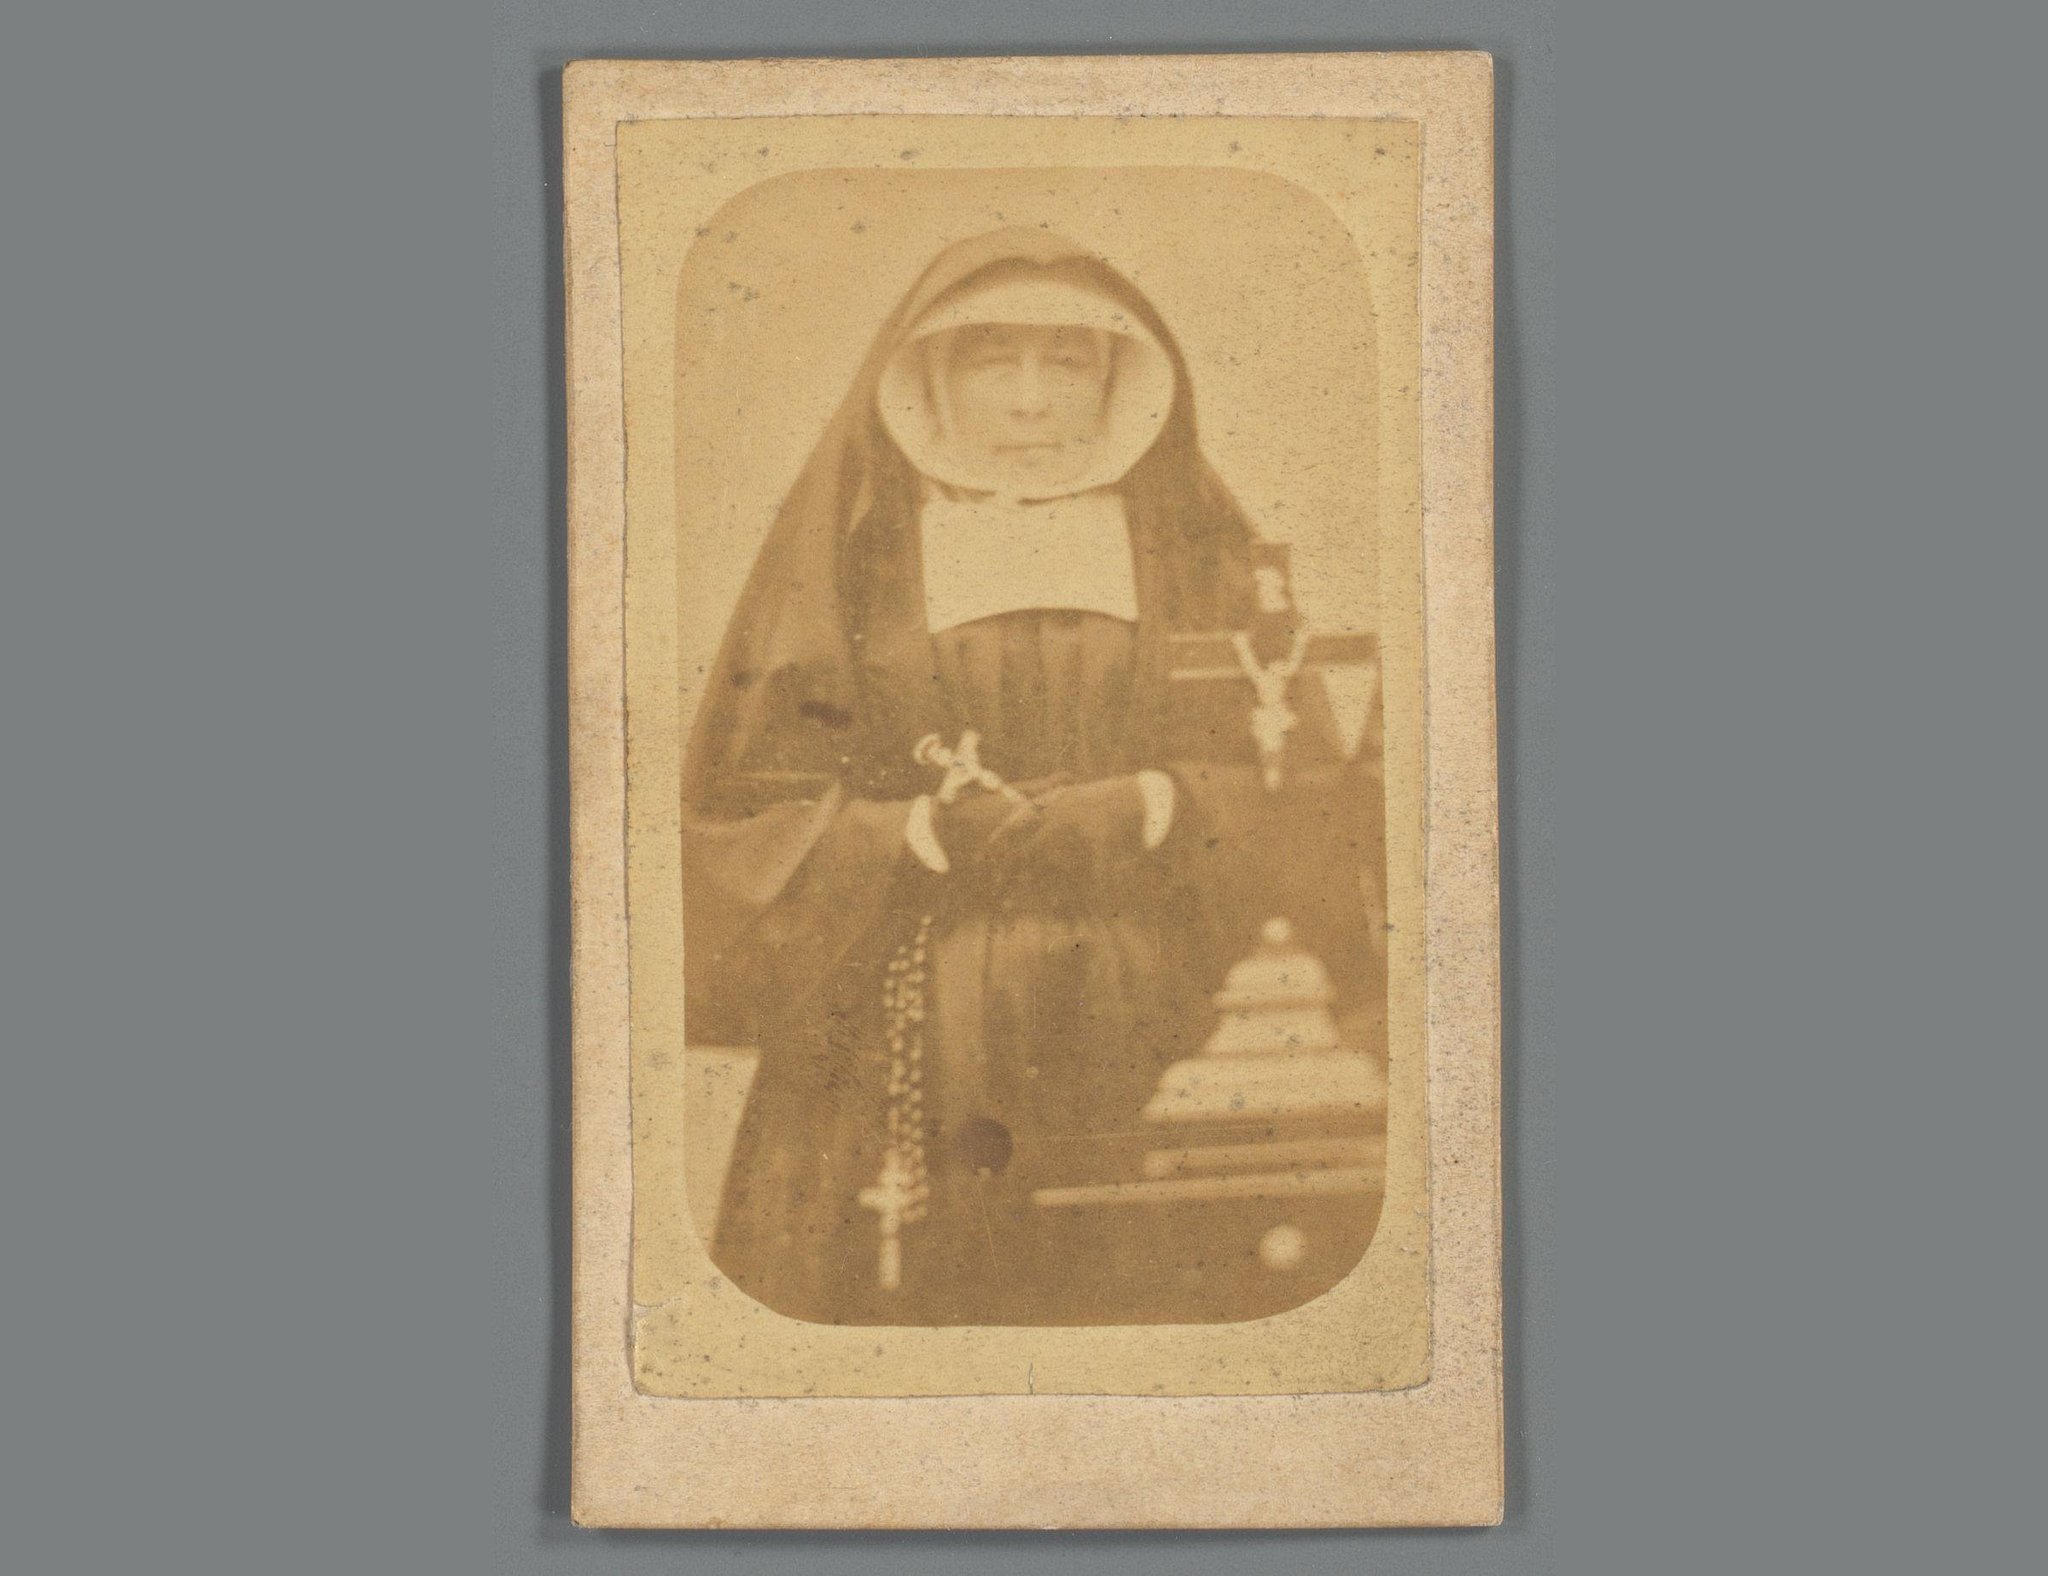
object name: photograph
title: Portret van Maria Theresia Arnoldina Moenen op bidprent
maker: Anonymous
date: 1877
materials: cardboard, paper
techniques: albumen print, letterpress printing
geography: turnhout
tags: nun(s), historical persons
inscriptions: inscription: ‘J.M.J.B./ Omdat gij aan God aangenaam waart (...) R.I.P./ Turnhout. - Snelpersdrukkerij van Splichal-Roosen.’